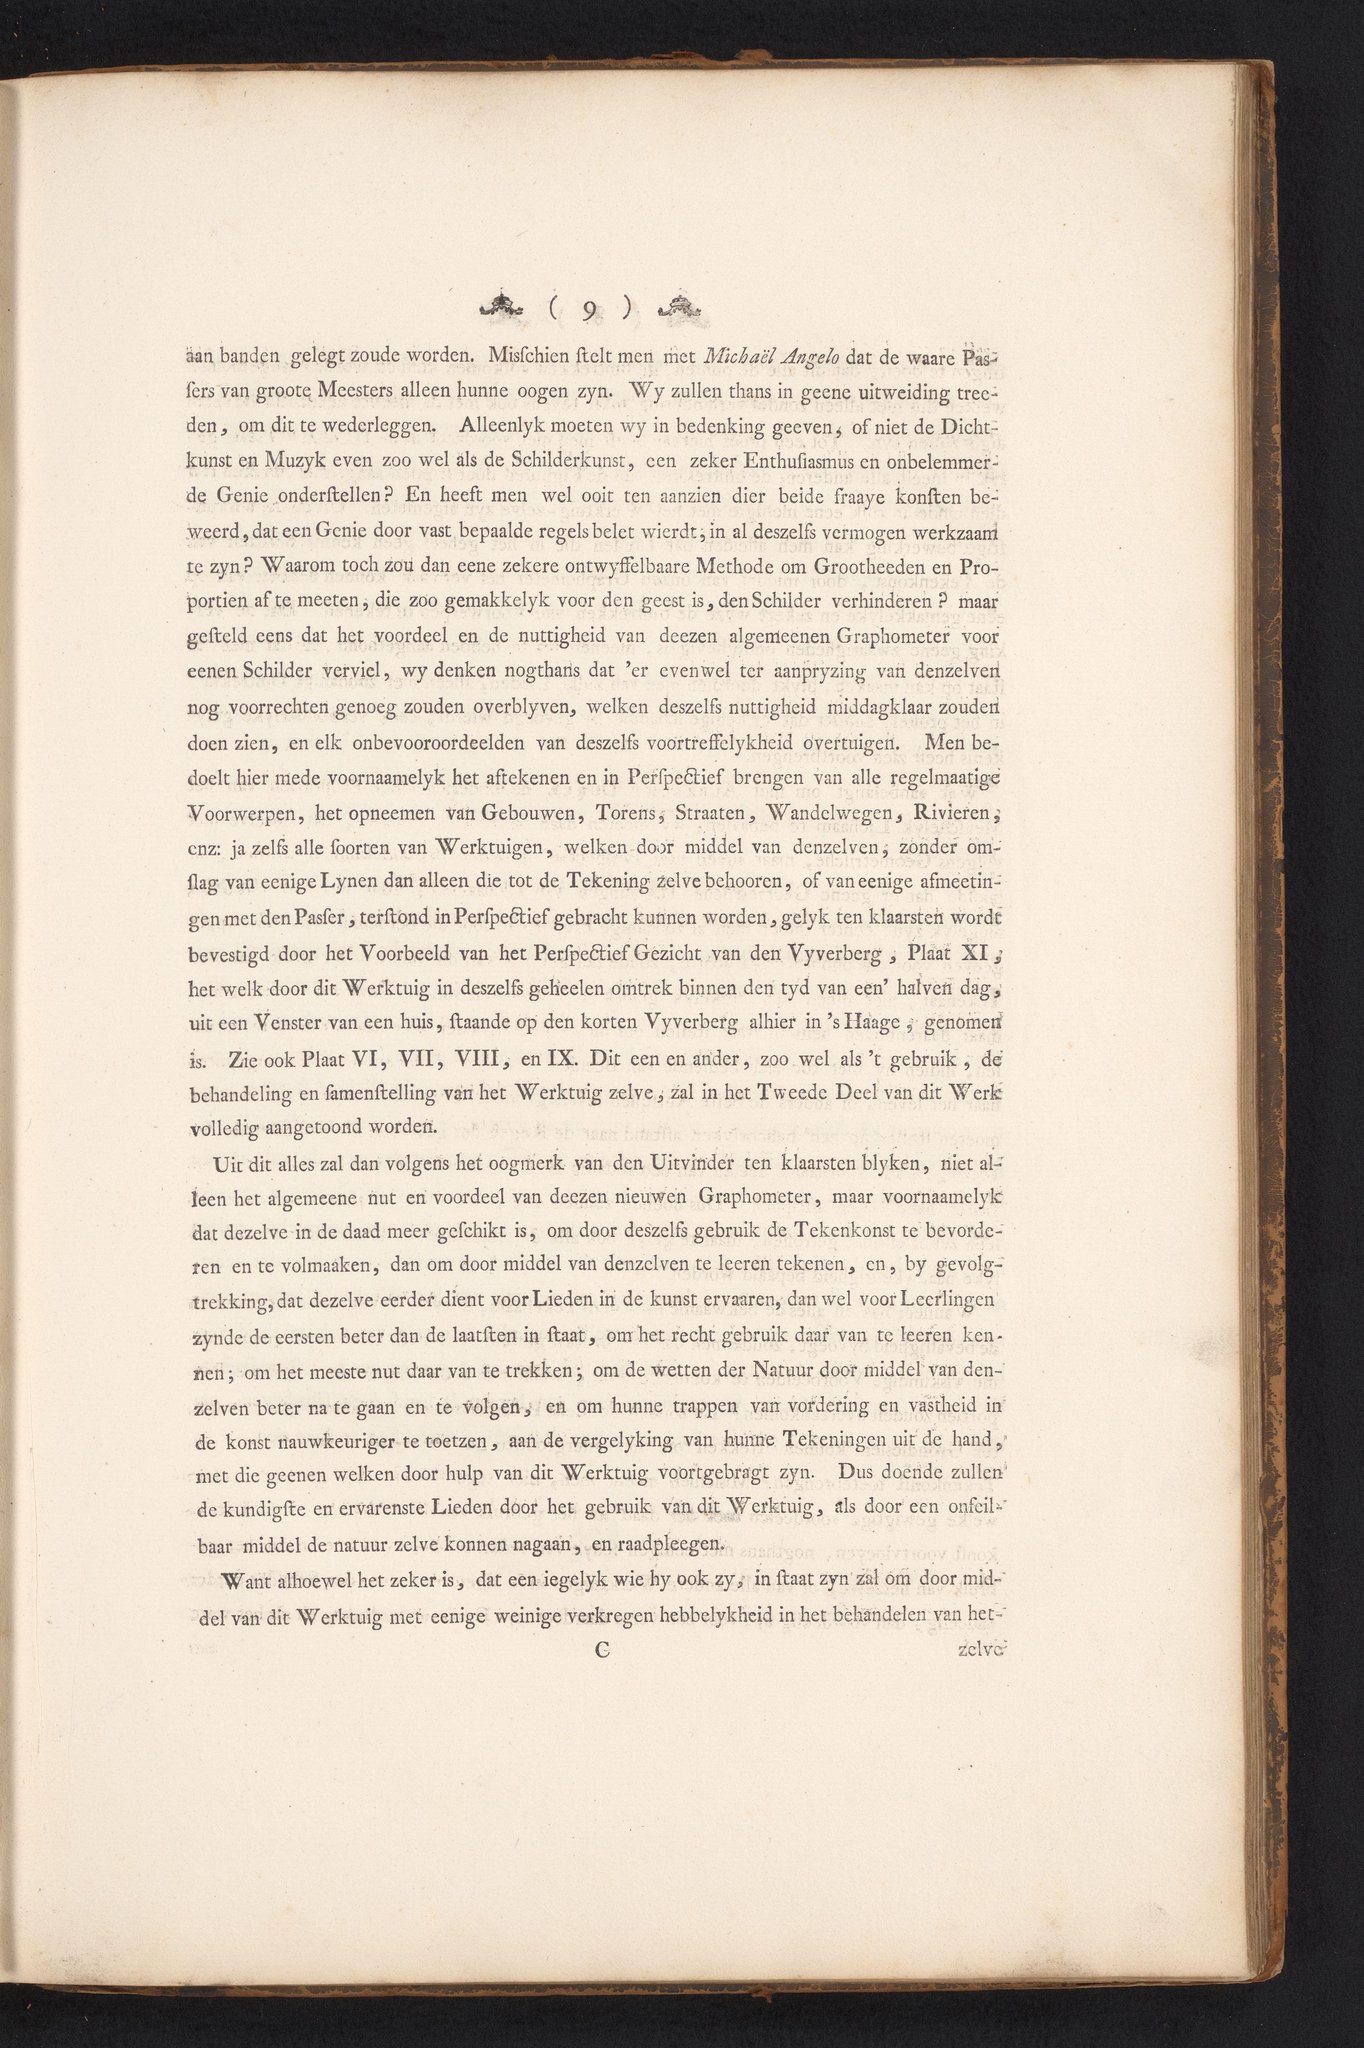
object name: text sheet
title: Beschryving van een' algemeenen graphometer. Eerste deel. Behelzende het nut van dit werktuig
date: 1777-1778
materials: paper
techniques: letterpress printing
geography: the hague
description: Het tekstblad maakt deel uit van het boek: A.G. Eckhardt, Beschryving van een algemeenen graphometer, 1778.